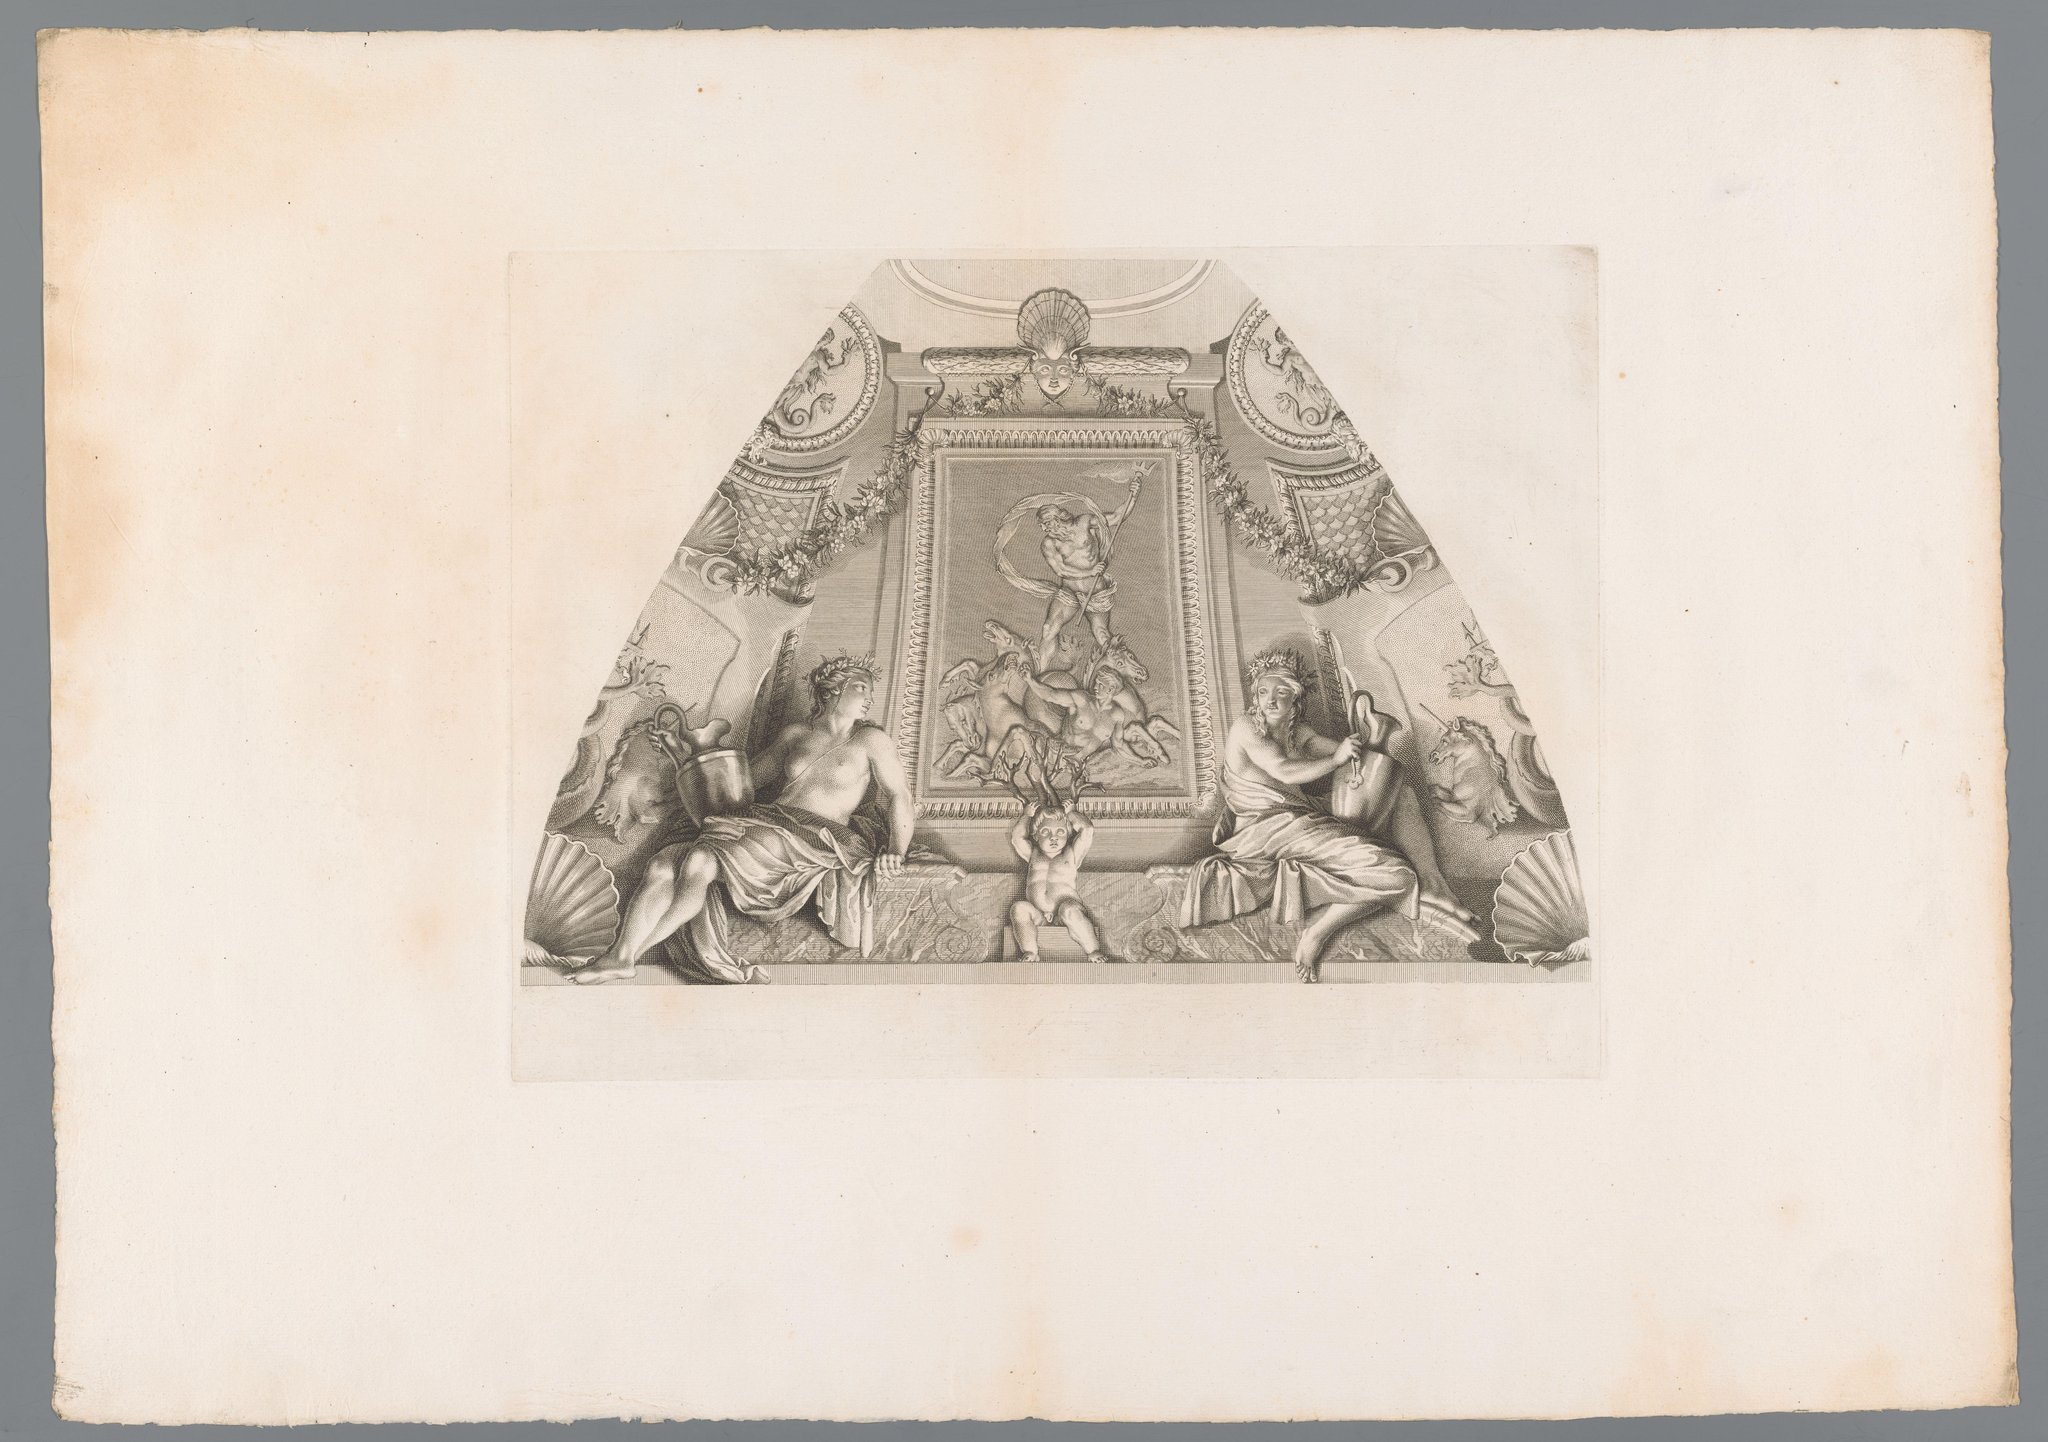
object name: print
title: Triomf van Neptunus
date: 1740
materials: paper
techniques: engraving, etching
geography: paris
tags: triumph of neptune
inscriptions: collector's mark: Lugt 2228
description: Grisaille, met de voorstelling van Neptunus met zijn drietand in de hand staande tussen zeepaarden, in de hoek van het plafond van de Chambre des Bains in het Hôtel Lambert. De voorstelling van Neptunus wordt geflankeerd door twee Nereïden, ieder met een waterkan. Midden onder een putto met een gewei van koraal op het hoofd. Prent maakt deel uit van een serie prenten naar de schilderijen in het Hôtel Lambert te Parijs.